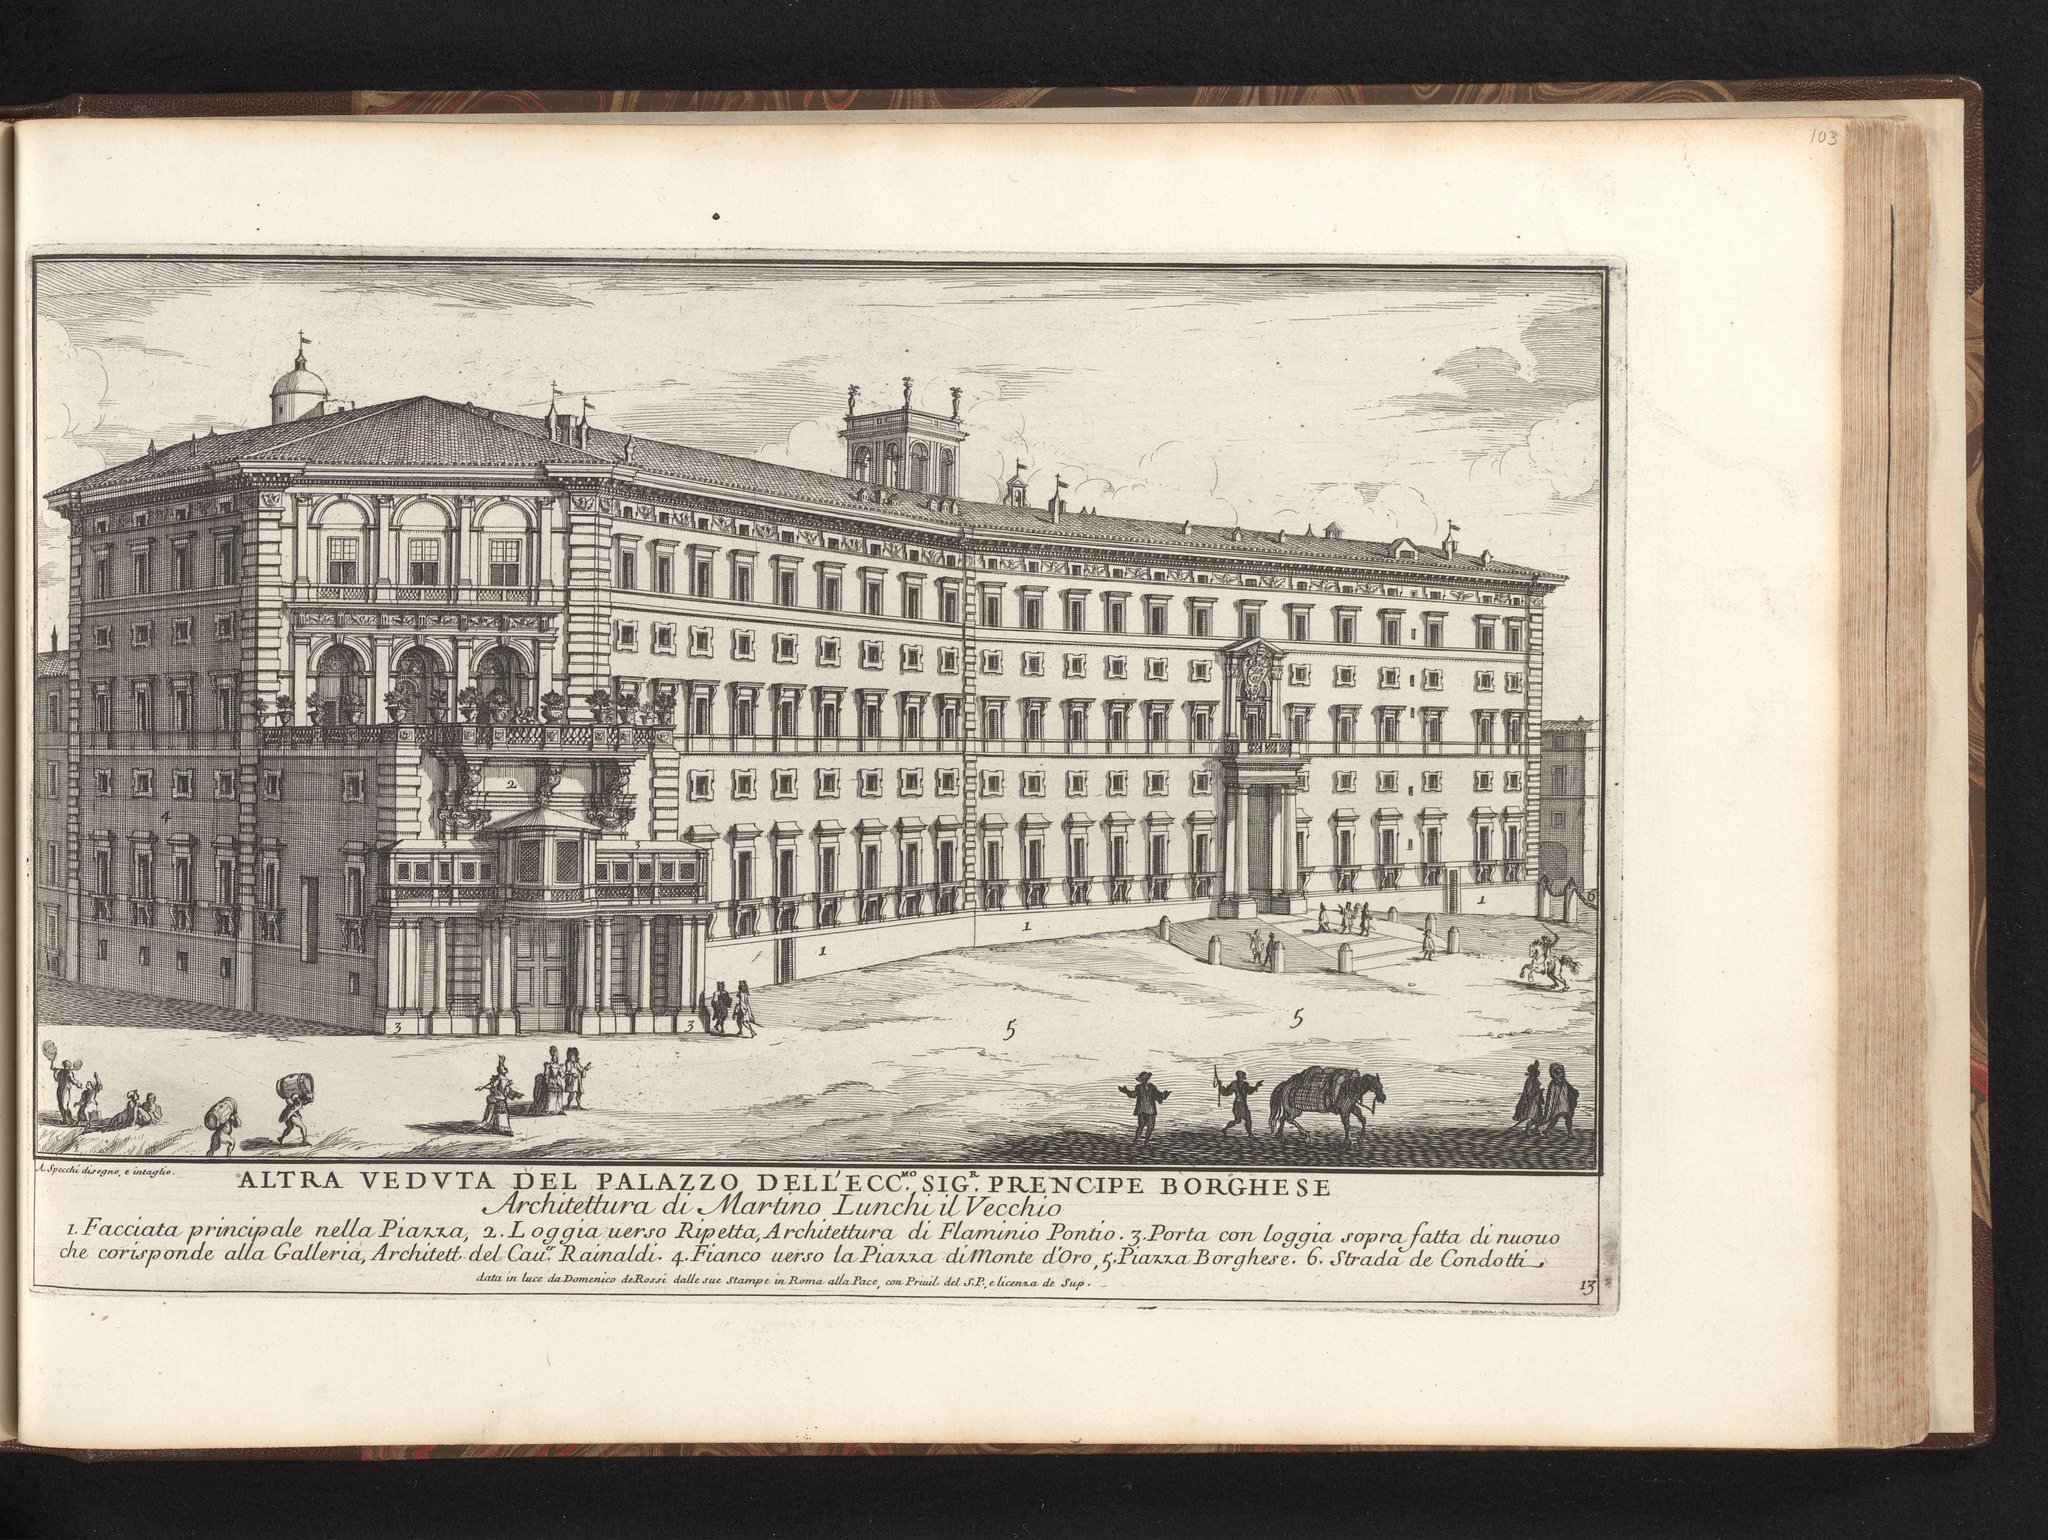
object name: print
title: Il nuovo teatro di Roma moderna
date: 1699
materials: paper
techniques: etching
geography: italy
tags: city-view, and landscape with man-made constructions, hôtel, i.e. small palace in city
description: Deze prent maakt deel uit van een reeks van 52 prenten met voorstellingen van paleizen in Rome. Samen met vier andere reeksen vormt het de grote reeks: 'Il nuovo teatro di Roma moderna'.